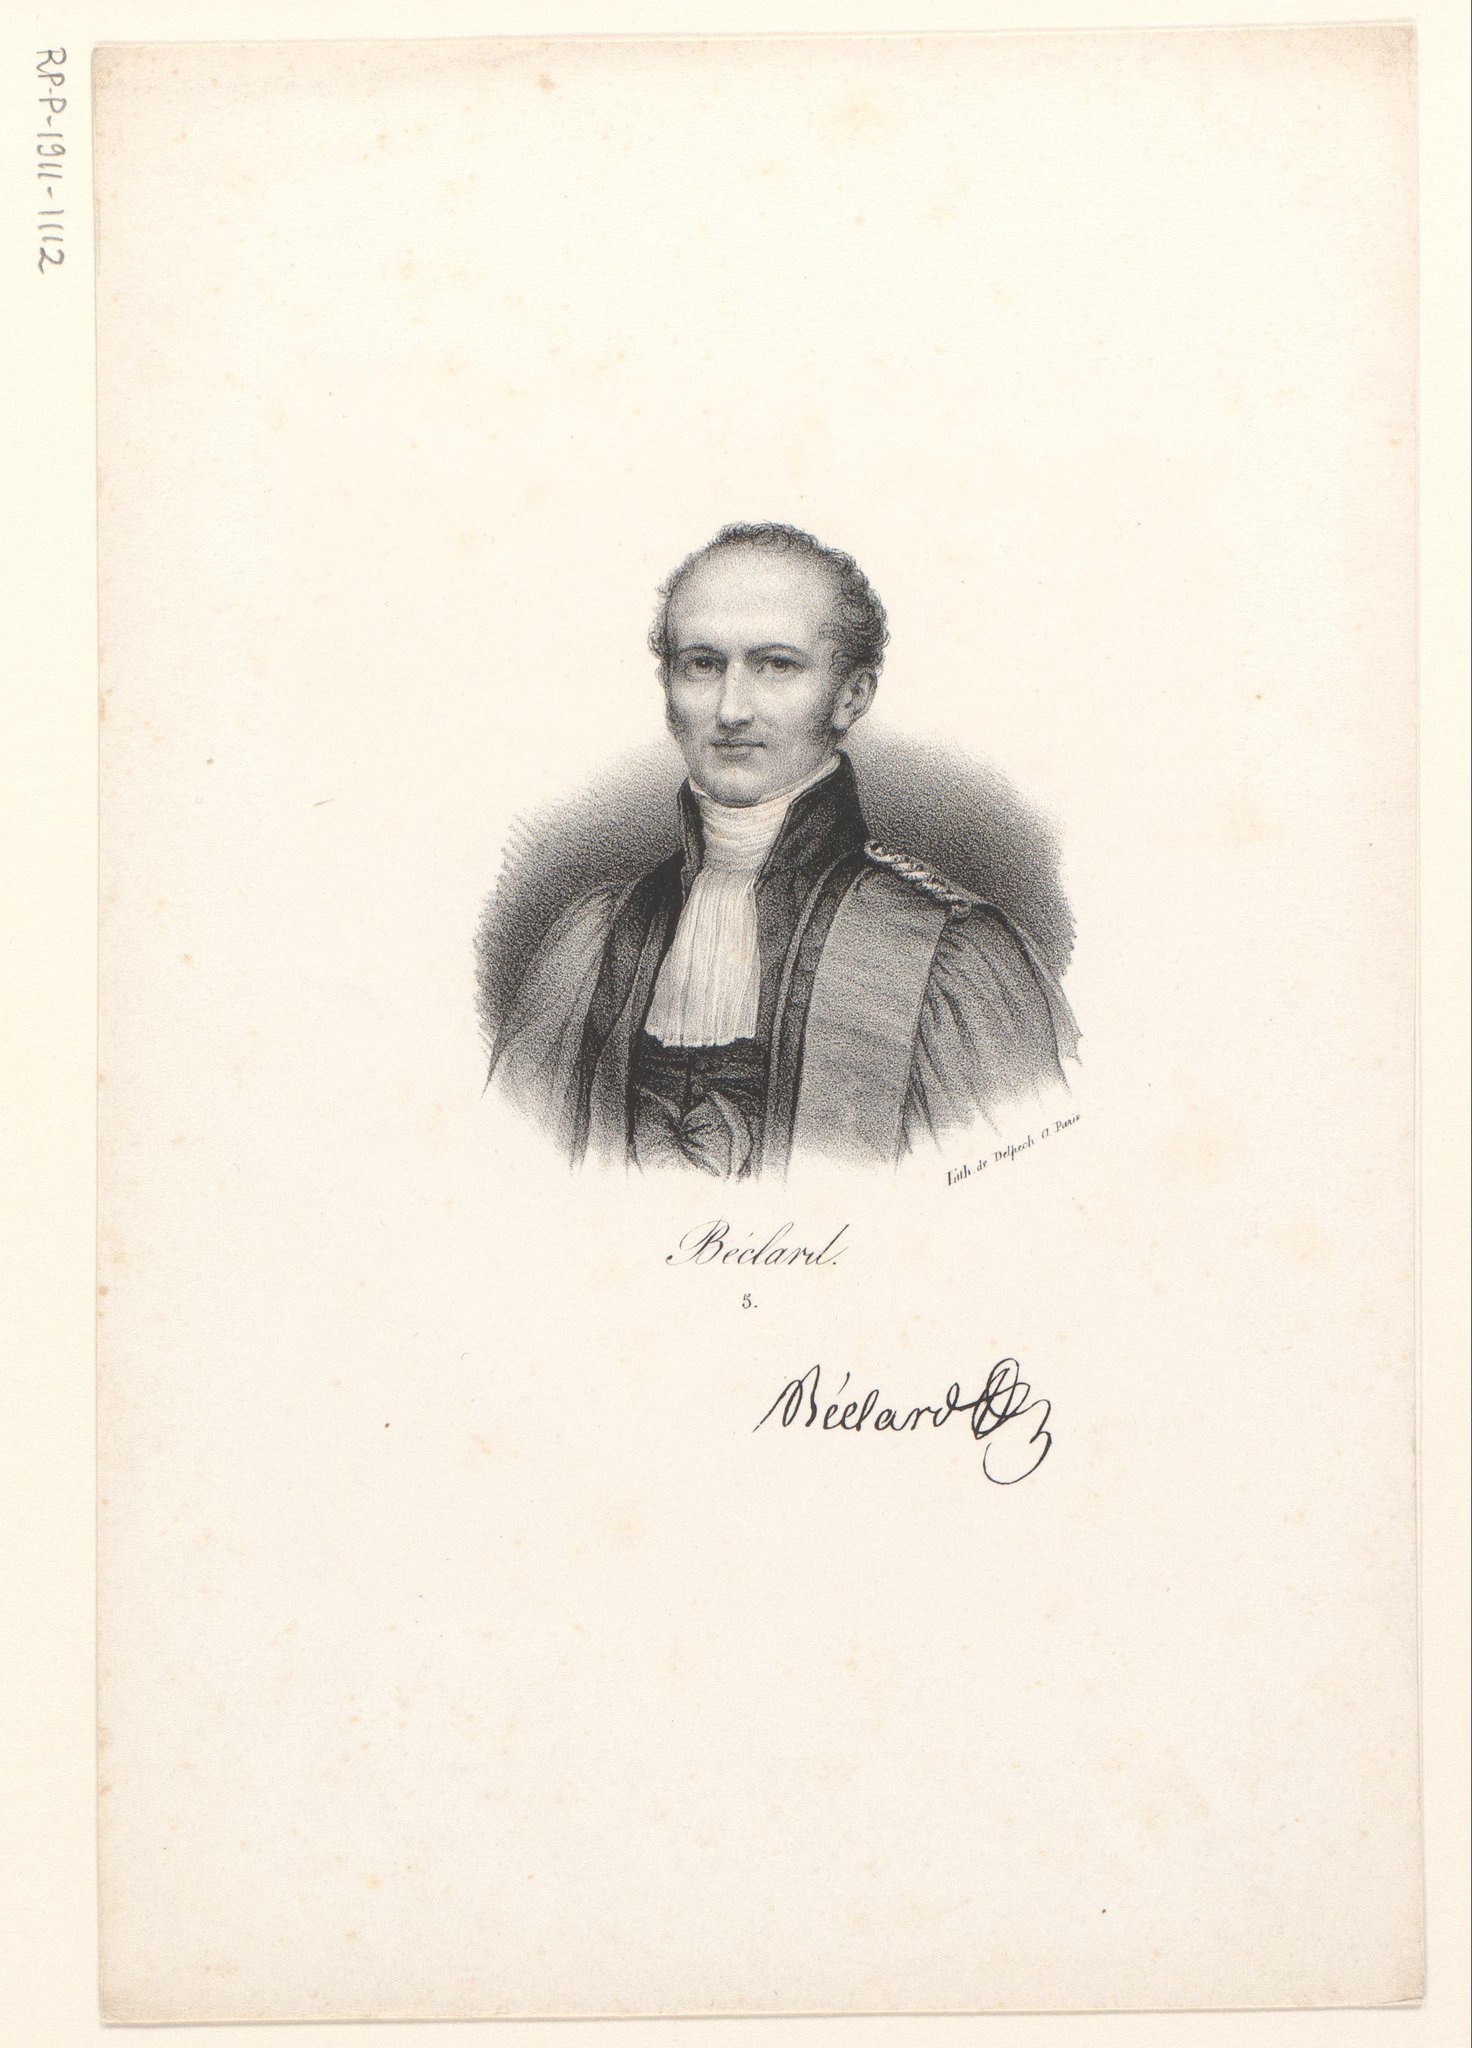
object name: print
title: Béclard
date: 1818-1842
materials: paper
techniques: lithograph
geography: paris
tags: historical persons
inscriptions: collector's mark: Lugt 2228a